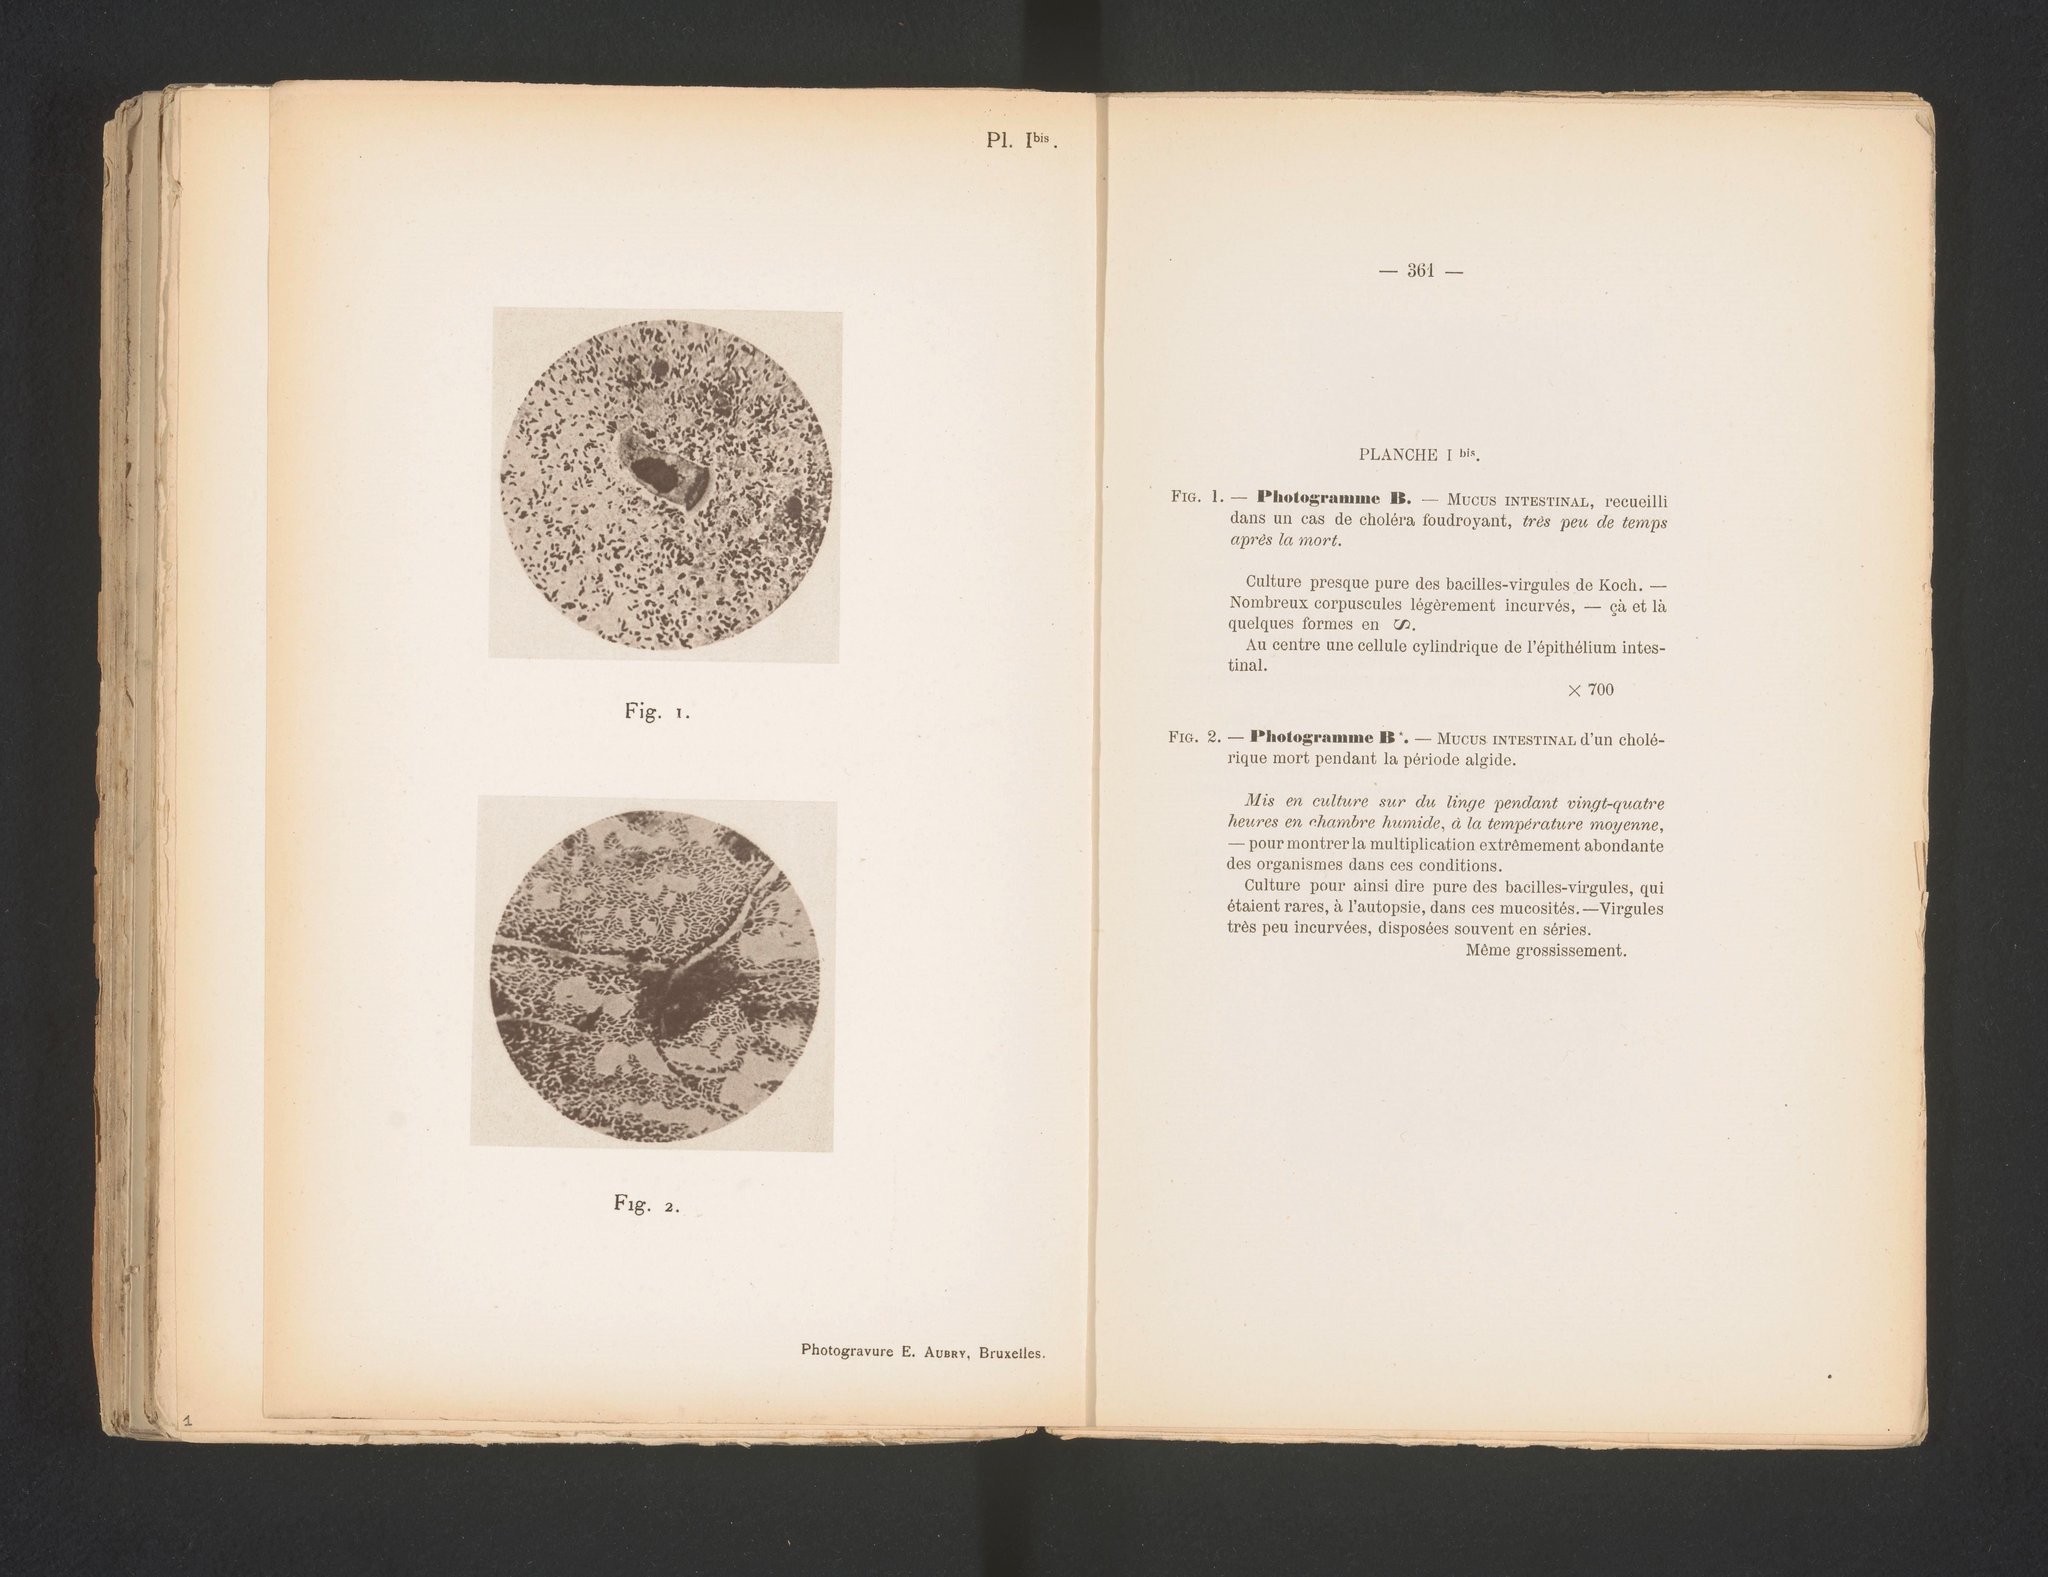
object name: page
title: Twee microscoopopnamen van het darmslijmvlies van iemand die is gestorven aan cholera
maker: émile van ermengem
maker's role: bioloog, fotograaf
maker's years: 1851-1932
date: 1875-1885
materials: paper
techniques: photograph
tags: diseases affecting the whole body, microscope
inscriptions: number: ‘Pl. Ibis. Fig. 1. Fig. 2.’, inscription: ‘Fig. 1.- Photogramme B. Mucus Intestinal, recueilli dans un cas de choléra foudroyant, très peu de temps après la mort (...) Fig. 2. - Photogramme B. Mucus Intestinal d'un cholérique mort pendant la période algide. (...)’